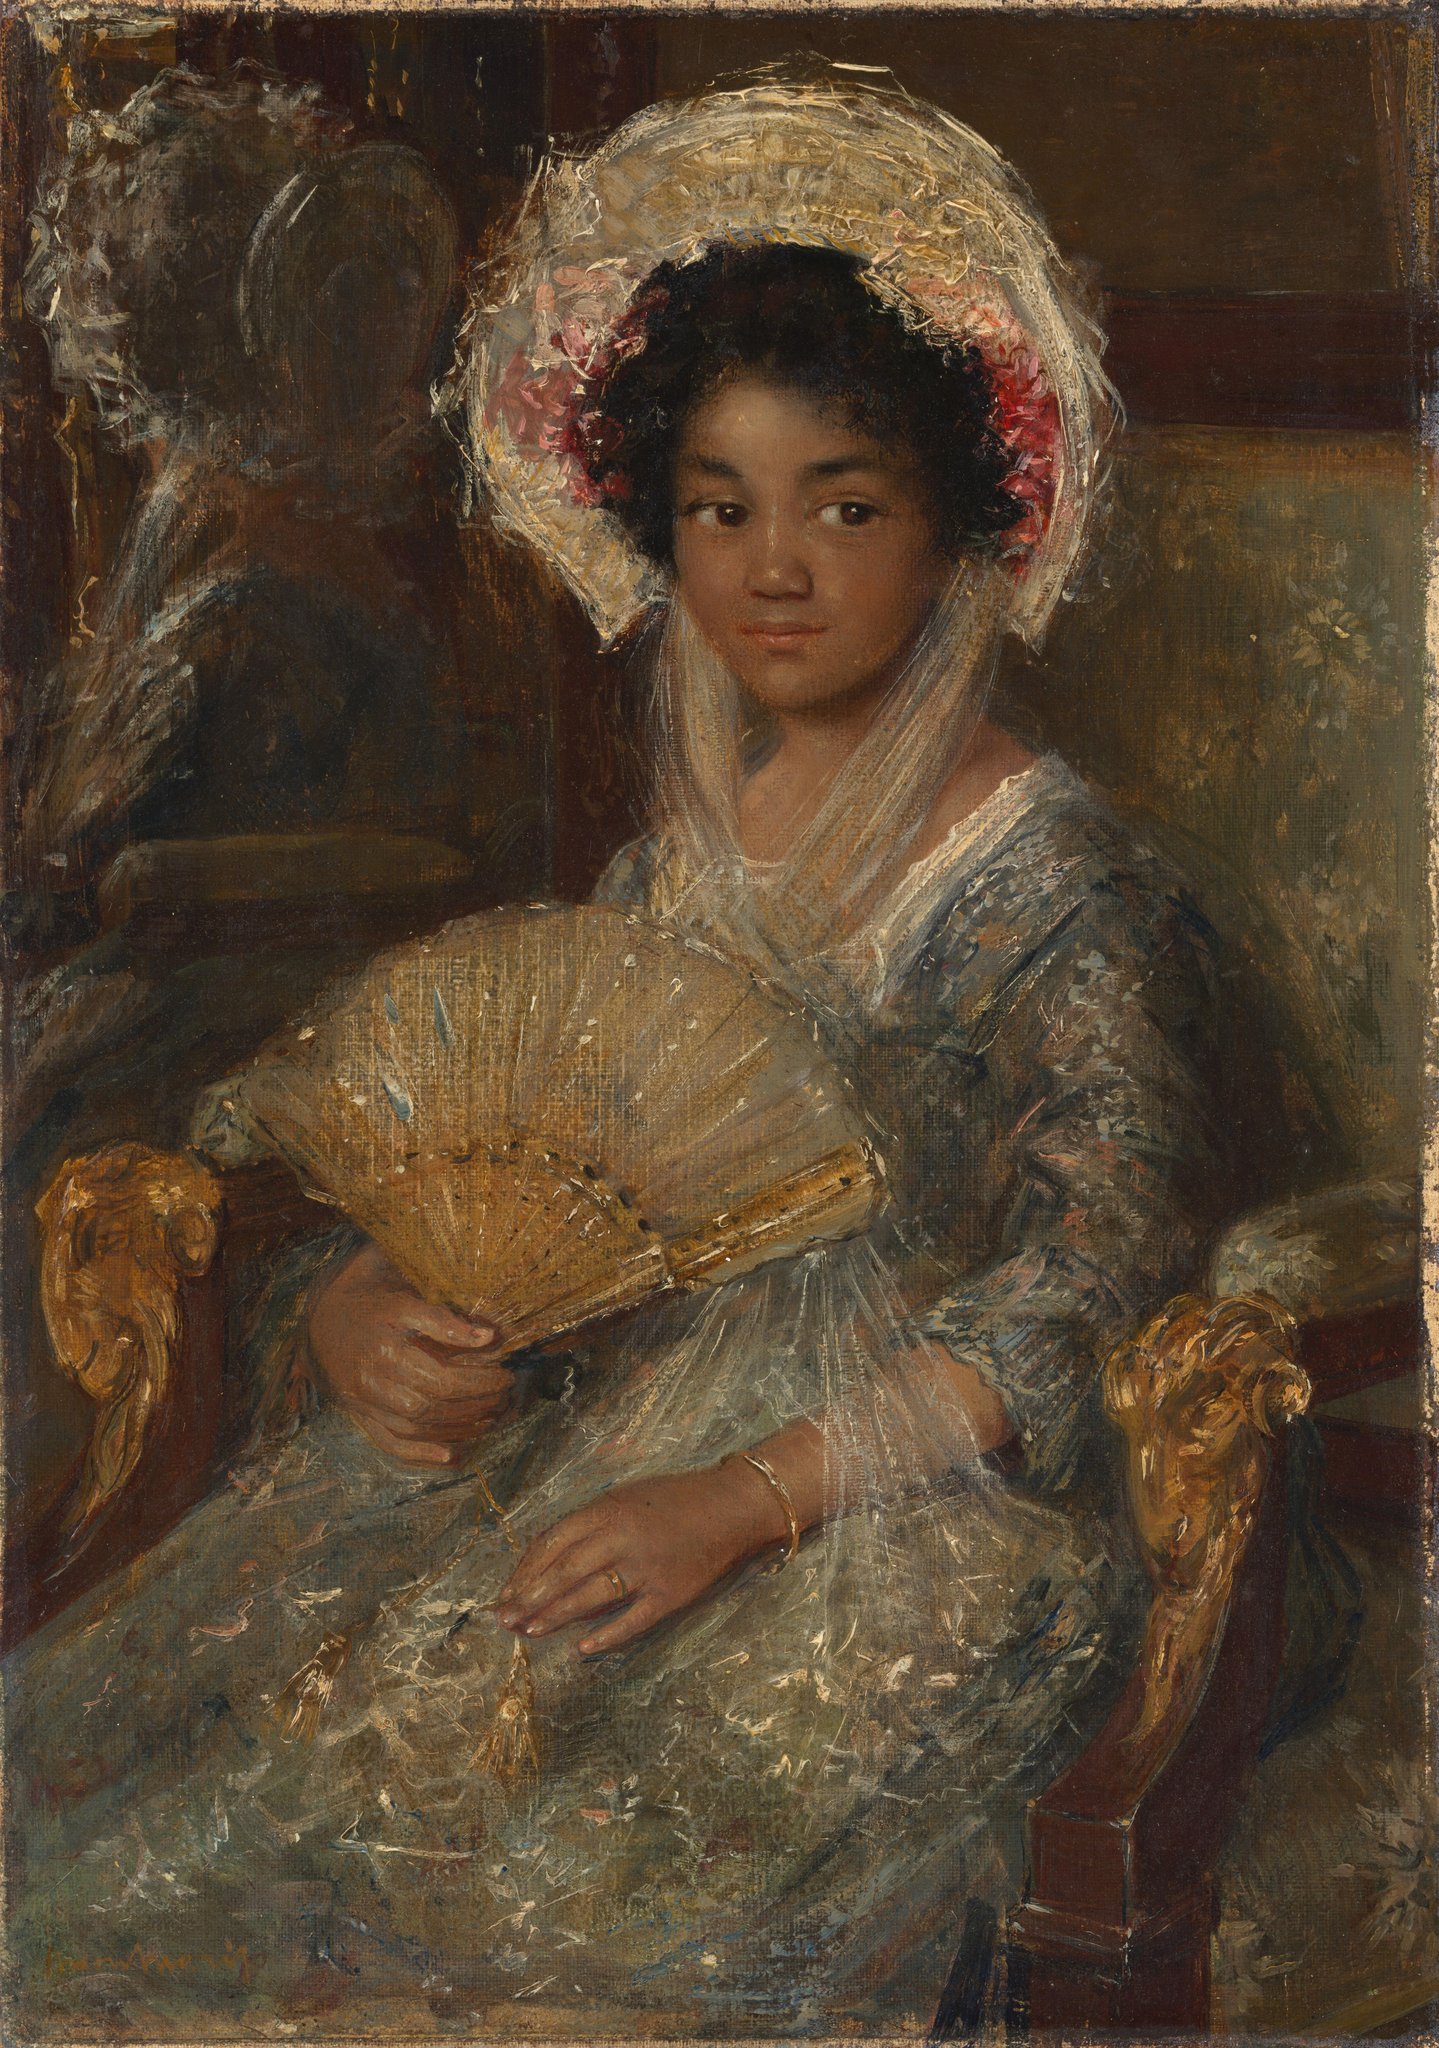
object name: painting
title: Isabella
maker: simon maris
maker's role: painter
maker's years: 1873-1935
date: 1906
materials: canvas, oil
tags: historical persons - bb - woman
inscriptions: signature: ‘Simon Maris’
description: In creating this portrait, Maris first took photographs of the young girl as reference material. Thanks to those pictures and other documents in Maris’ archive, we know the girl was about twelve years old when she posed for him. Maris made several portraits of her, some bearing the title Isabella, including this painting. This was possibly not her real name, as models commonly used aliases.